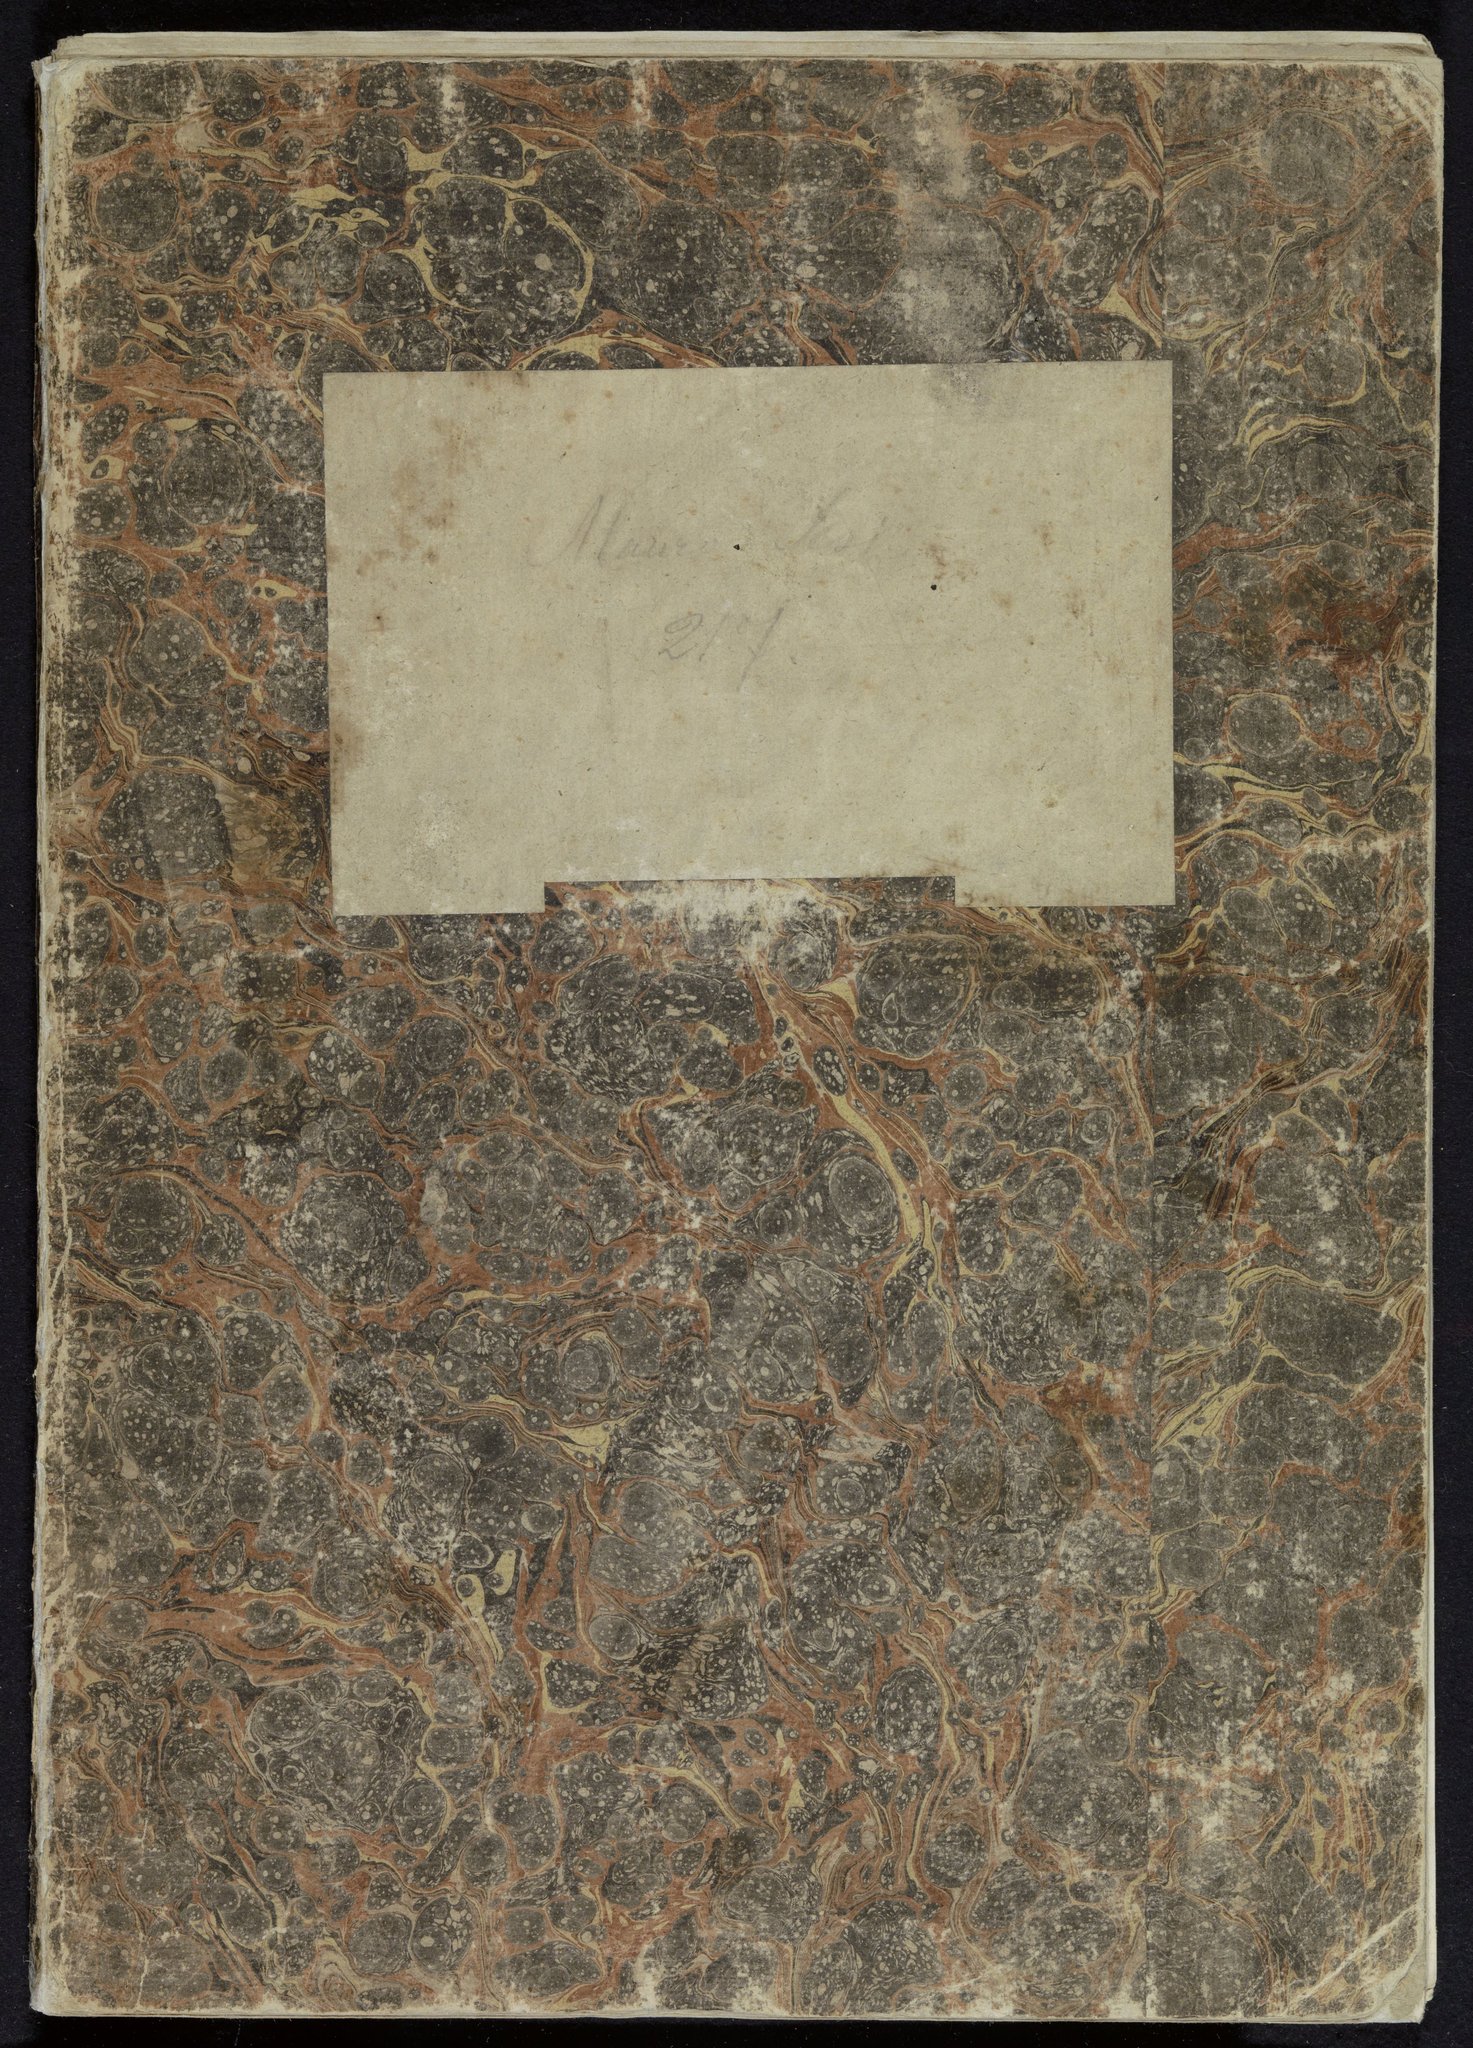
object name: prentrecueil, prentenalbum, prentalbum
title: Raccolta di dissegni originali di Mauro Tesi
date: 1787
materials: cardboard, paper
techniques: aquatint, etching, letterpress printing, marbling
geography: bologna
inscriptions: date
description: Band met negen bladen met tekst in boekdruk en etsen in aquatint gedrukt in verschillende kleuren naar getekende architectuurontwerpen en fantasiearchitectuur van Mauro Tesi uit verschillende Italiaanse collecties. Het album is incompleet en bevat 28 van de 42 platen.